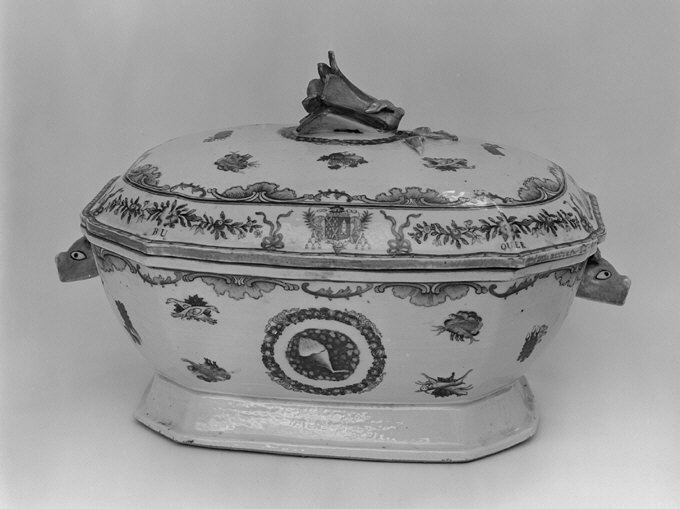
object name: tureen with cover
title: Tureen with cover (part of a service)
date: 1765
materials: hard paste porcelain